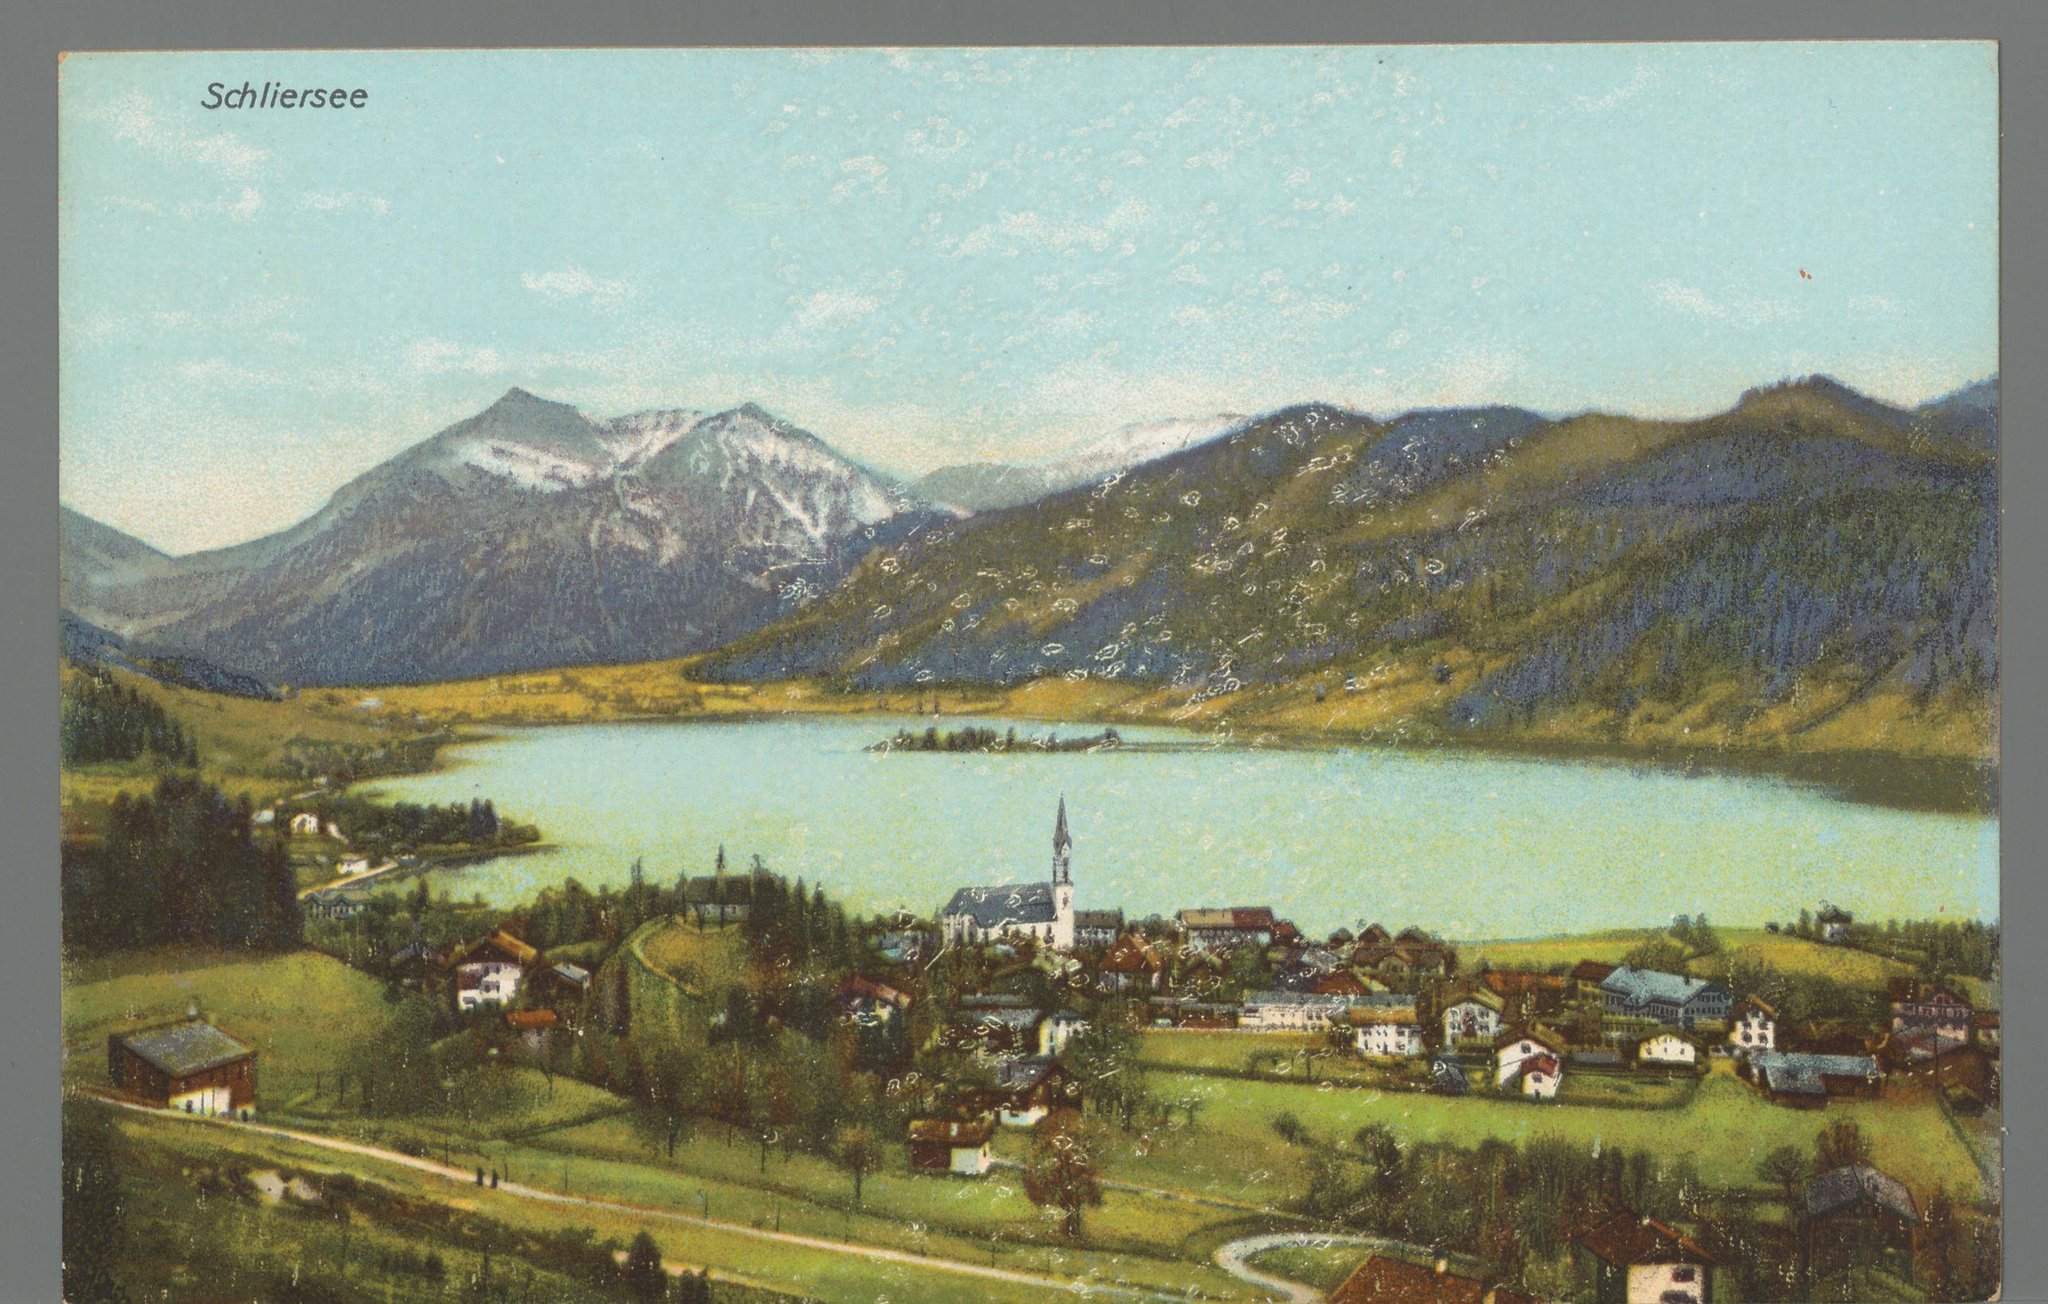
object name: print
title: Schliersee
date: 1905-1930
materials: cardboard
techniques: lithograph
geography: schliersee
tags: lake, mountains